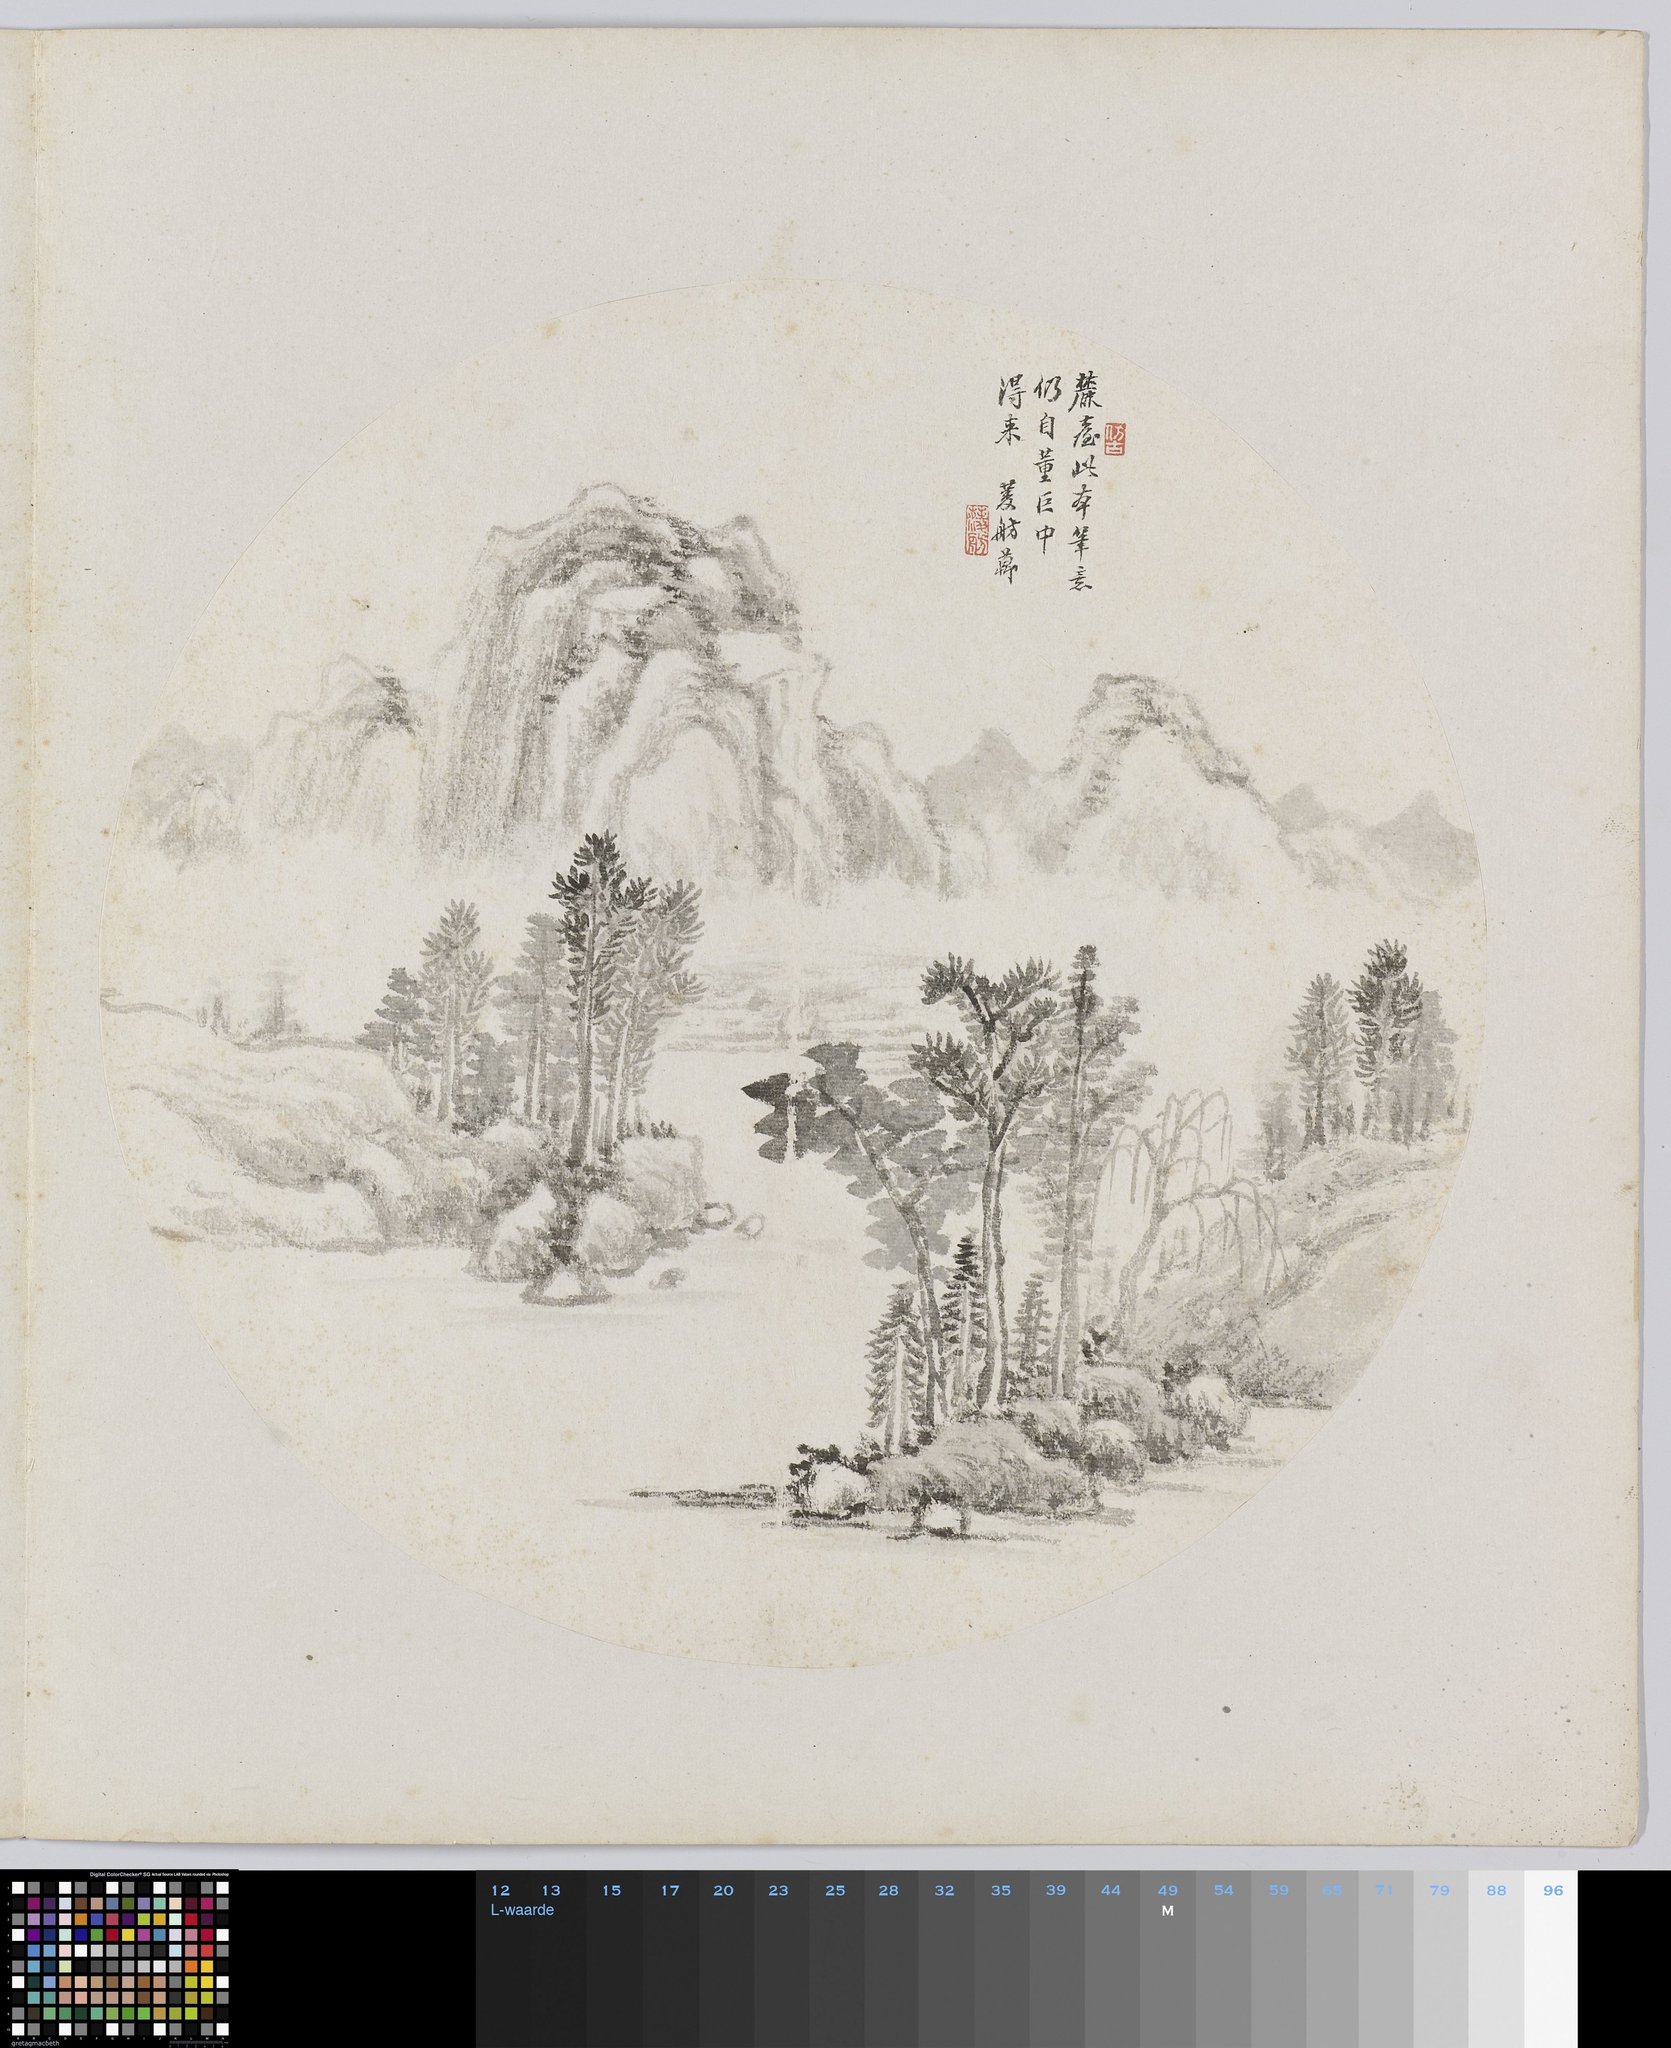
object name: painting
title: Albumblad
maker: hui nian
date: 1850-1900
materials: ink, paper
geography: china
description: Albumblad met een landschap. Behoort twee albums met 24 landschappen in de stijl van diverse meesters.